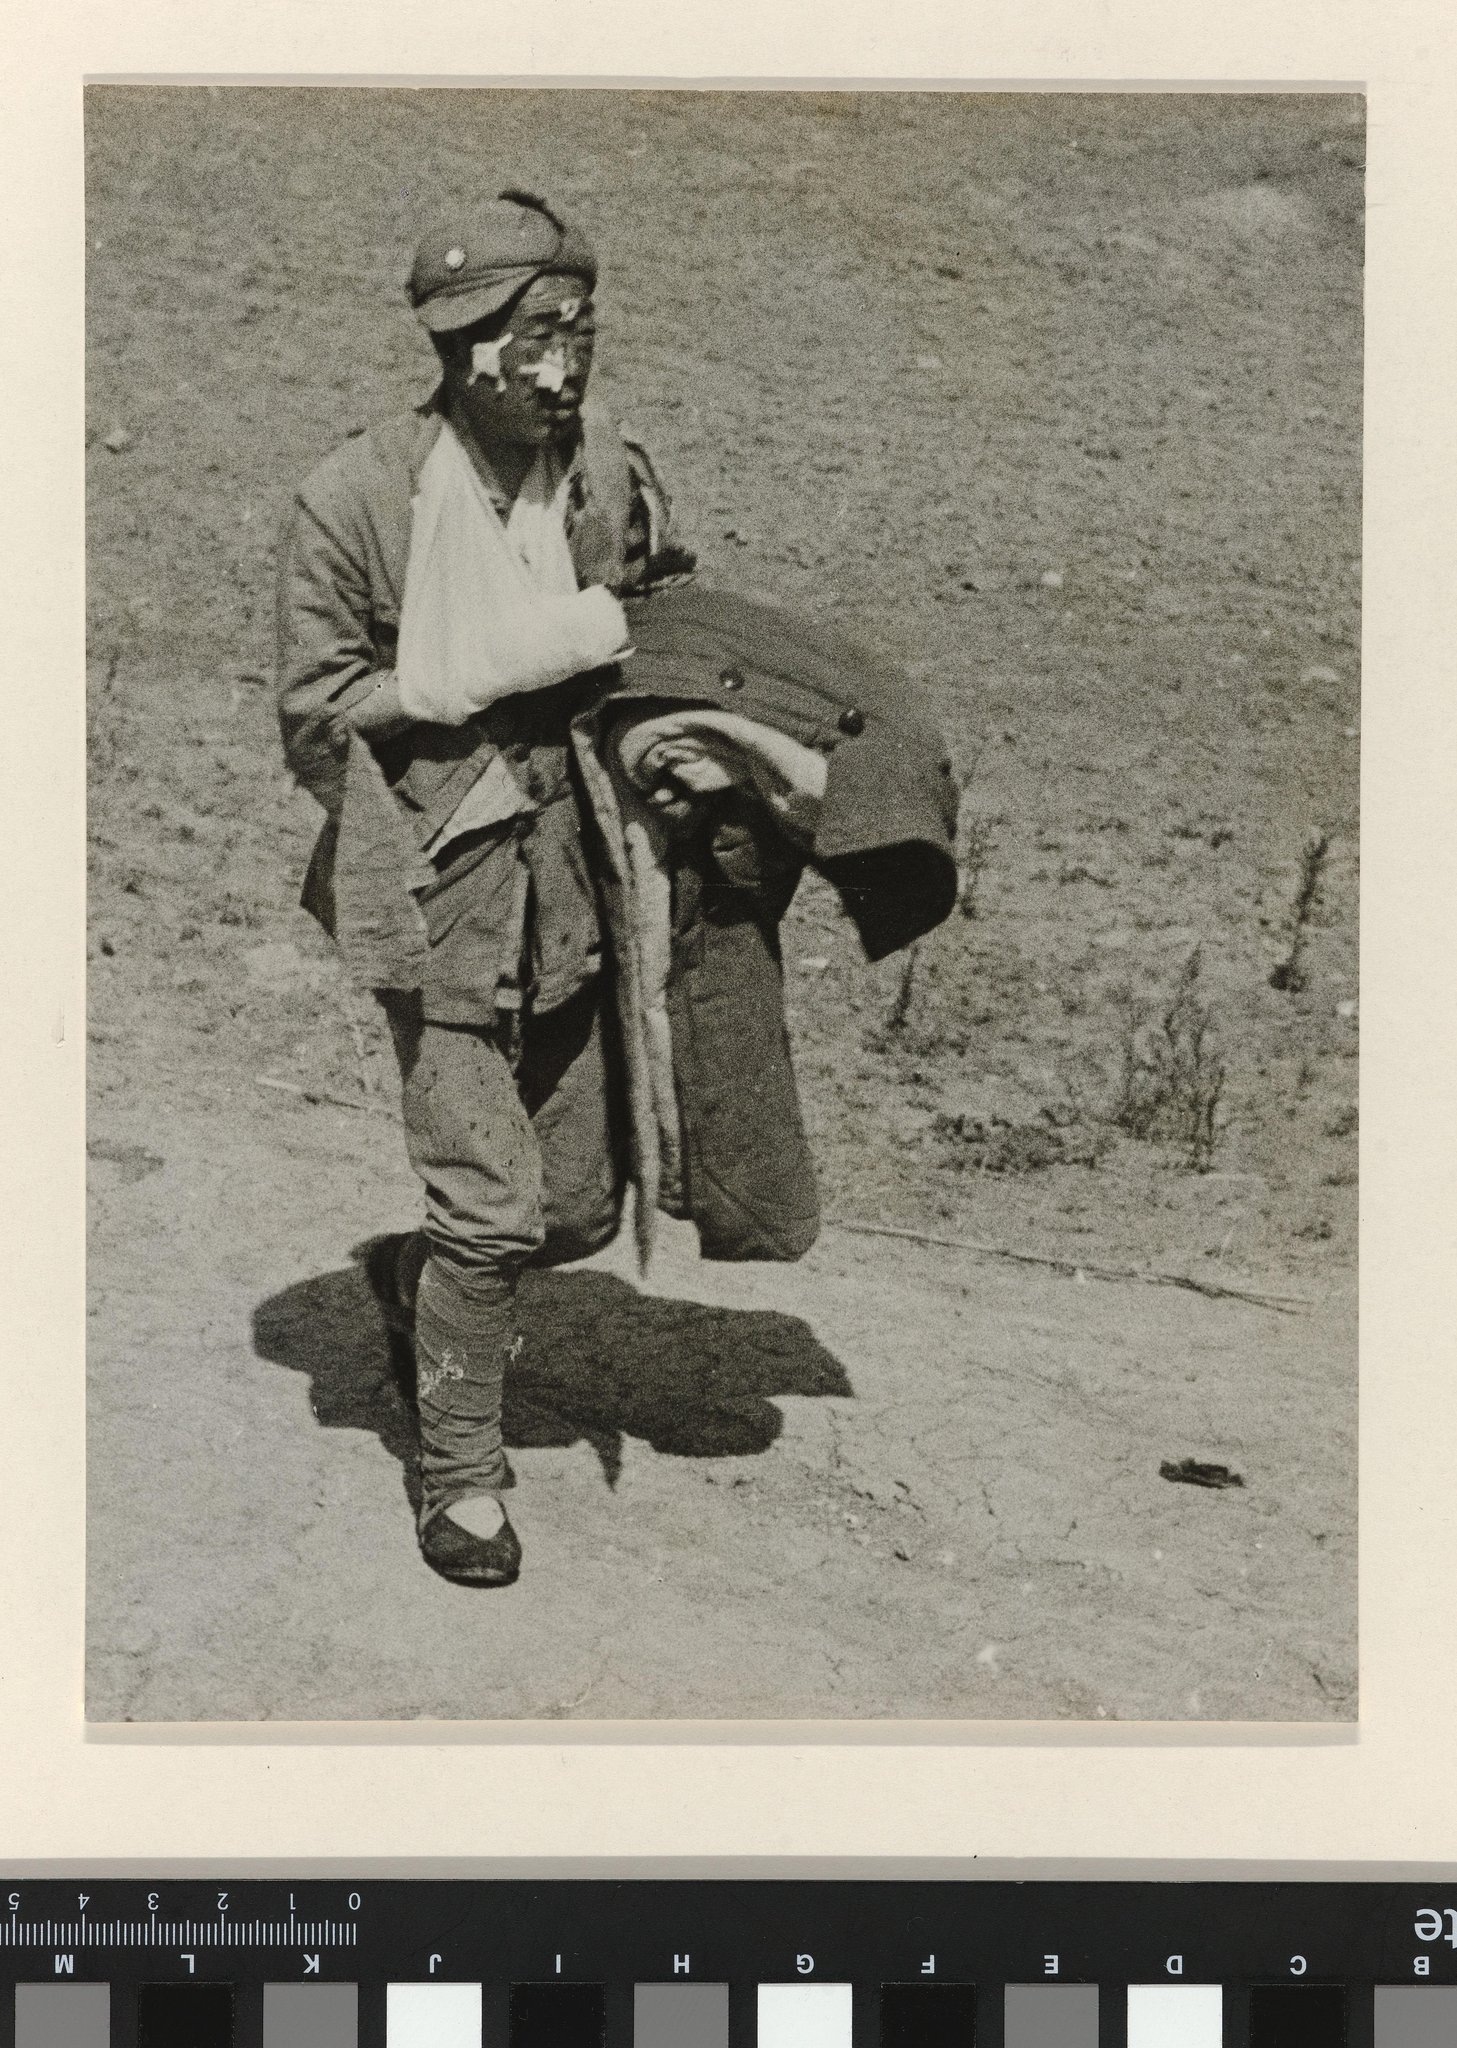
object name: news photograph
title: Gewonde soldaat in de slag om Tai'erzhuang, aan het front van Xuzhou, China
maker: robert capa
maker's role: fotograaf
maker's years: 1913-1954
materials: paper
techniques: gelatin silver print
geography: shandong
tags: disabled soldier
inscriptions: number: ‘10/ 18’, stamp: ‘PHOTO BY:/ PIX PUBLISHING INC./ 250 PARK AVENUE/ NEW YORK CITY/ TEL. ELDORADO 5-4021/ PLEASE CREDIT ROBERT CAPA - PIX/ THIS PICTURE IS SOLD TO YOU FOR YOUR/ PUBLICATION ONLY AND MUST NOT BE/ LOANED, SYNDICATED OR USED FOR AD-/ VERTISING PURPOSES WITHOUT WRITTEN/ PERMISSION FROM US.’